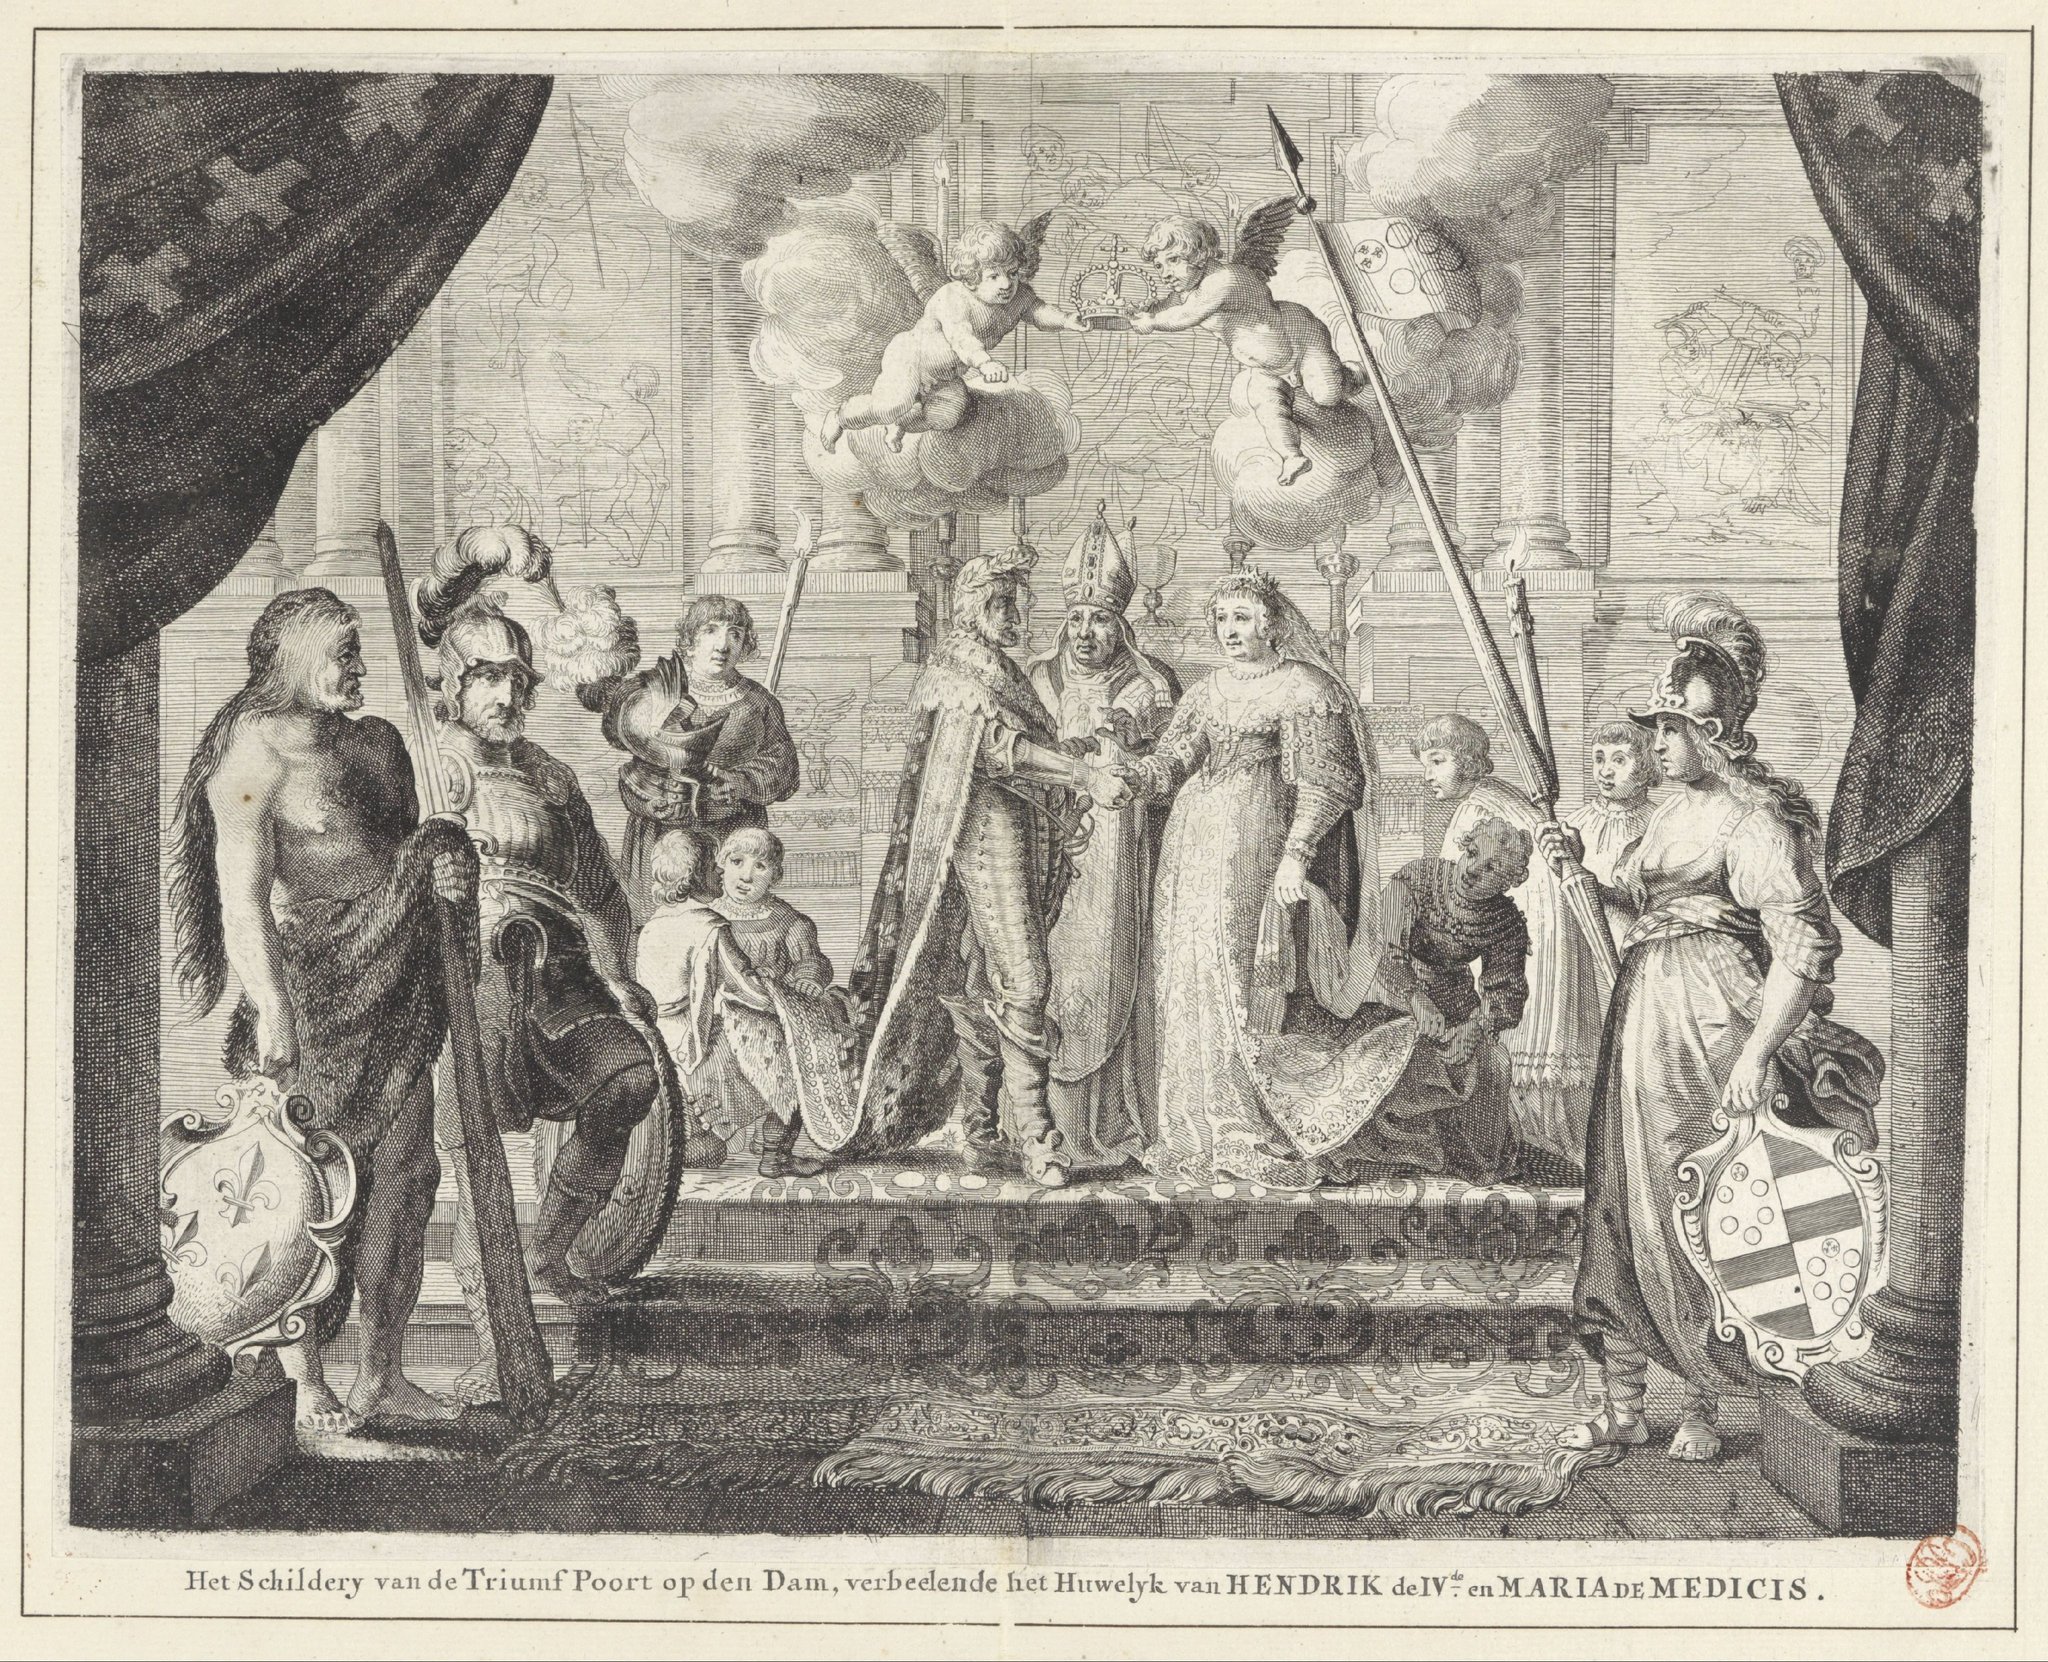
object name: book illustration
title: Feestelijkheden bij het bezoek van Maria de' Medici aan Amsterdam in 1638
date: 1638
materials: ink, paper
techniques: engraving, etching, pen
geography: amsterdam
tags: cologne, print maker, maria de' medici, paris, hendrik iv (koning van frankrijk en navarra), triumphal entry and public reception, pageant, 'entrée solennelle', 'joyeuse entrée', blessing the married couple, (civil) marriage ceremonies, amsterdam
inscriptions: inscription: ‘Het Schildery van de Triumf Poort op den Dam, verbeelende het Huwelyk van Hendrik de IV.de en Maria de Medicis’, collector's mark: Lugt 2228, collector's mark: Lugt 195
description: Prent ook gebruikt in:* Baerle, Caspar van. Medicea hospes, sive descriptio publicae gratulationis, qua Serenissimam, Augustissimamque Reginam, Mariam de Medicis (…). Amsterdam: Johannes en Cornelis Willemsz. Blaeu, 1638. En in: Baerle, Caspar van. Marie de Medicis, entrant dans Amsterdam : ou, histoire de la reception faicte à la Reyne Mere du Roy tres-Chrestien (…). Amsterdam: Johannes en Cornelis Willemsz. Blaeu, 1638. En in: Baerle, Caspar van en Joost van den Vondel. Blyde inkomst der allerdoorluchtighste koninginne, Maria de Medicis t' Amsterdam. Vertaelt uit het Latijn (…). Amsterdam: Johannes en Cornelis Willemsz. Blaeu, 1639. * Doorgaans zijn de prenten in de bovengenoemde publicaties rechtsonder genummerd (van de huidige prent is dat de derde bekende staat). Maar er zijn ook exemplaren waarin eerdere, ongenummerde, staten van de prenten (van de huidige prent de eerste en tweede bekende staat) zijn ingebonden.